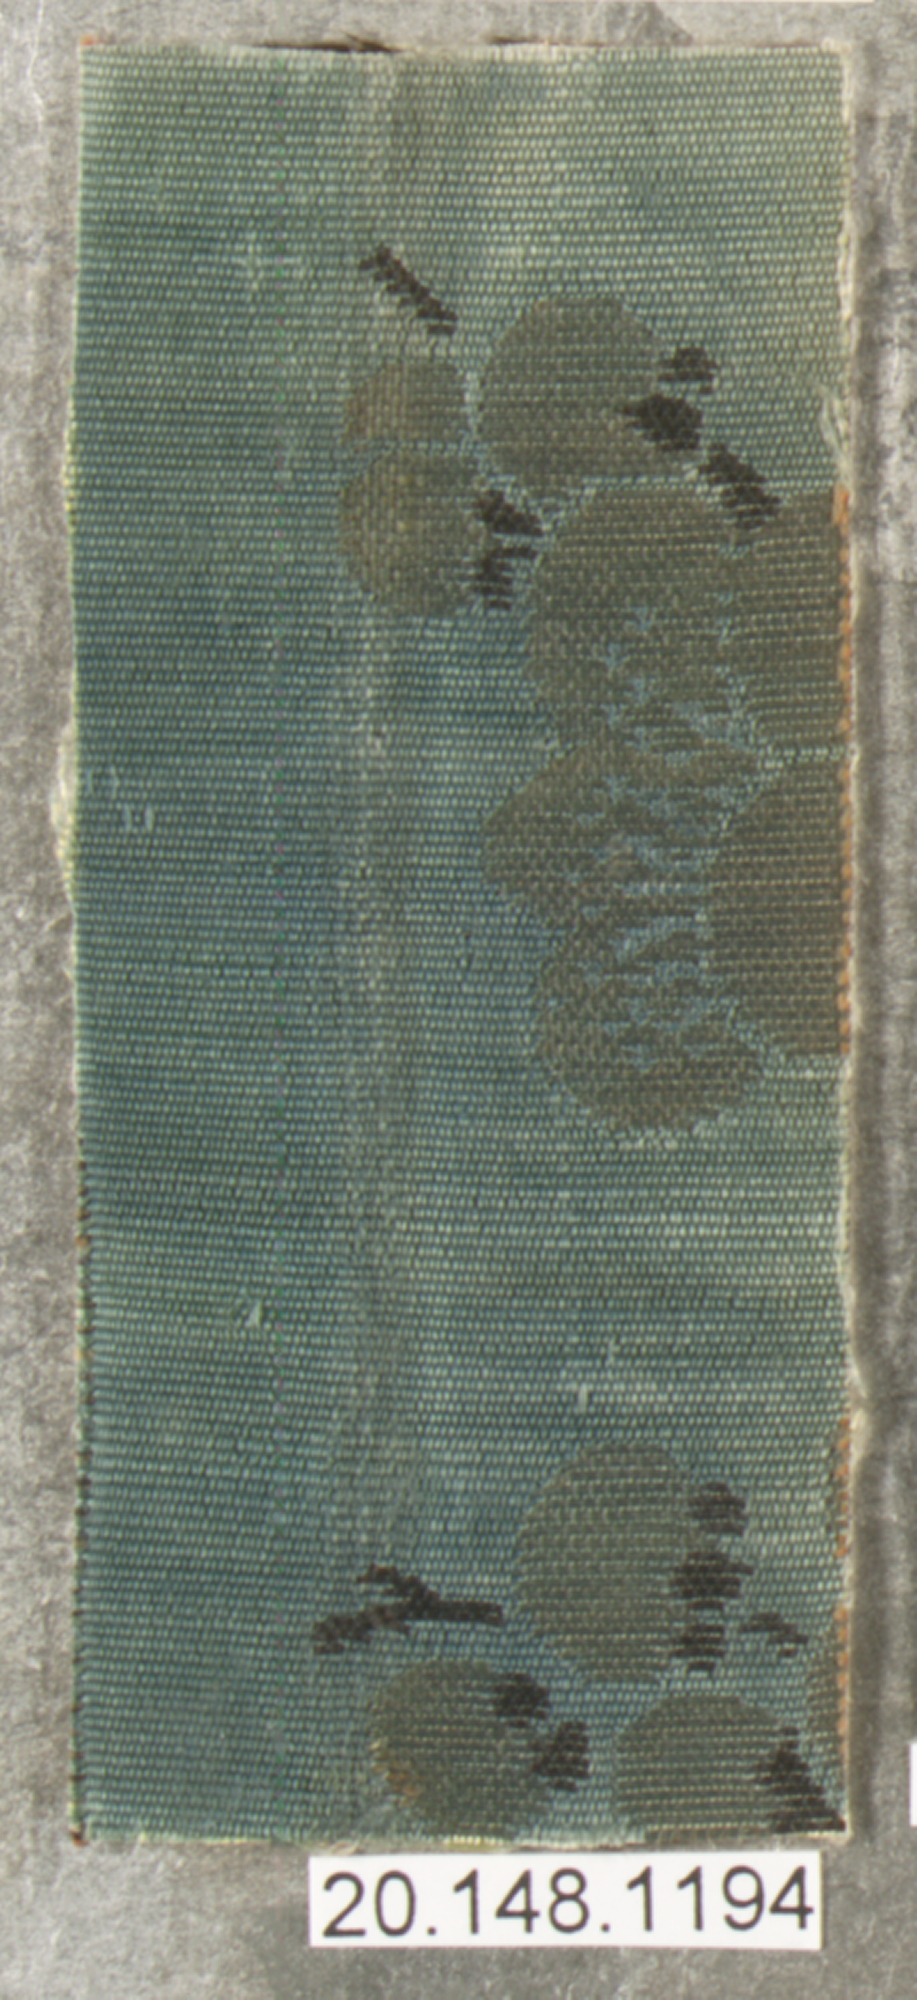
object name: piece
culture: japanese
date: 1701-1800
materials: silk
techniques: compound weave